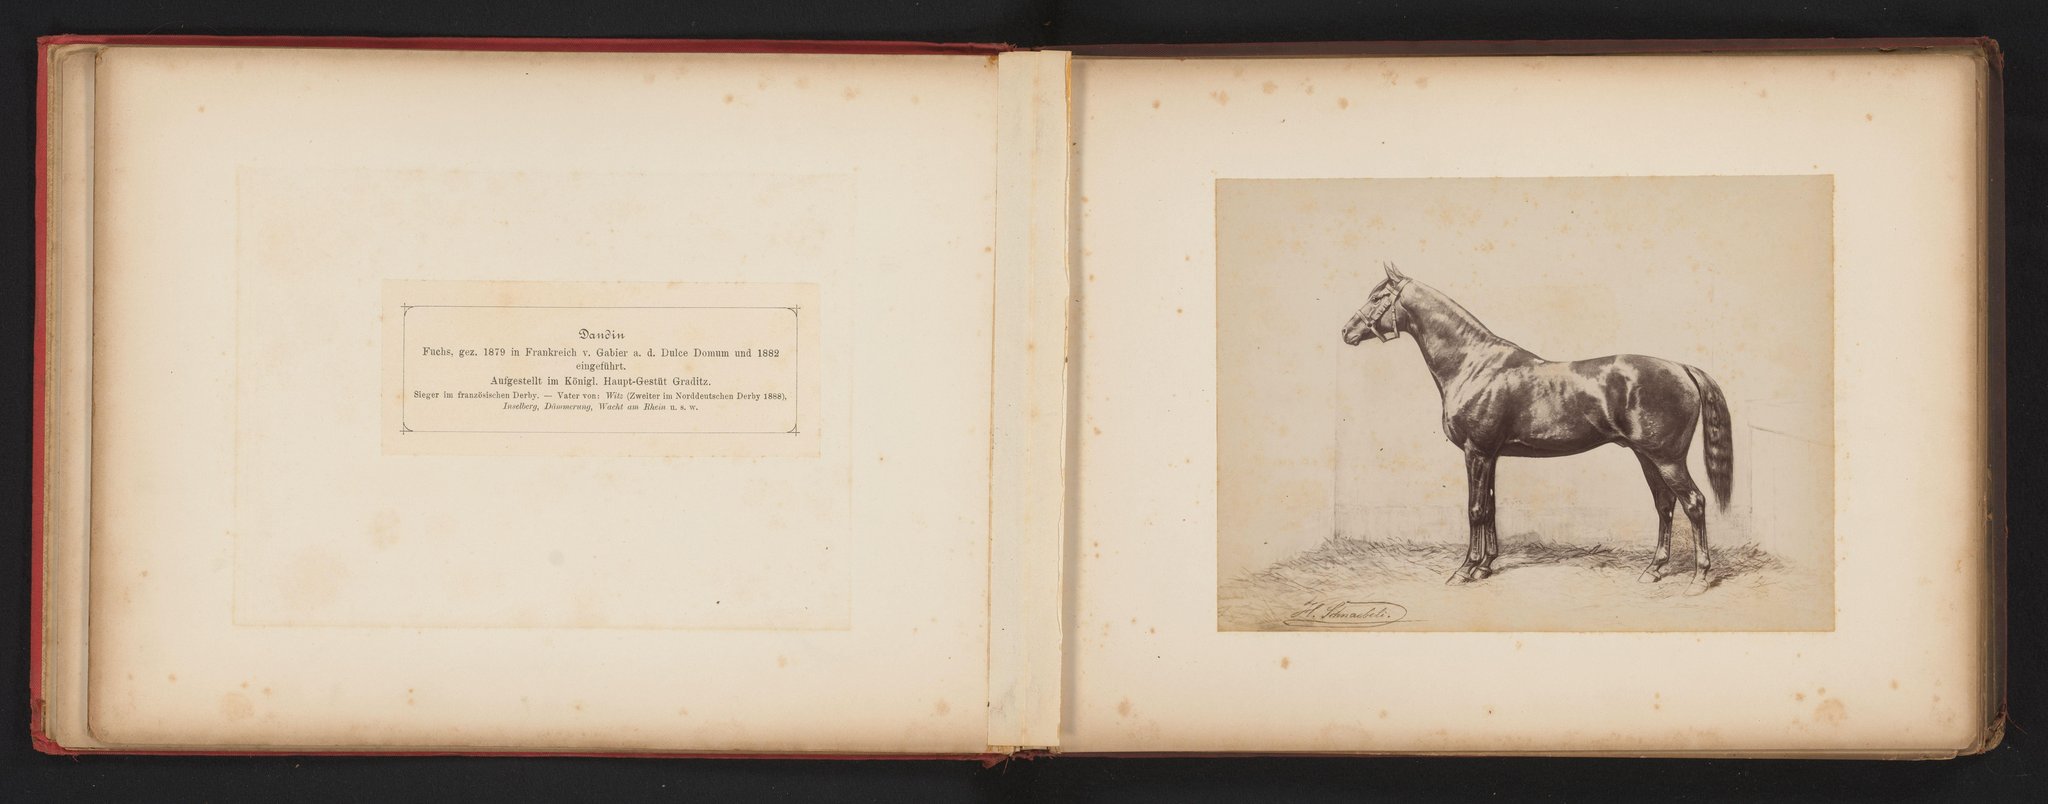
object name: reproduction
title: Fotoreproductie van een tekening van een paard, genaamd Dandin, door H. Schnaebeli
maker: h. schnaebeli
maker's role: fotograaf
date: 1894-1915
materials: photographic support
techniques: albumen print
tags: horse